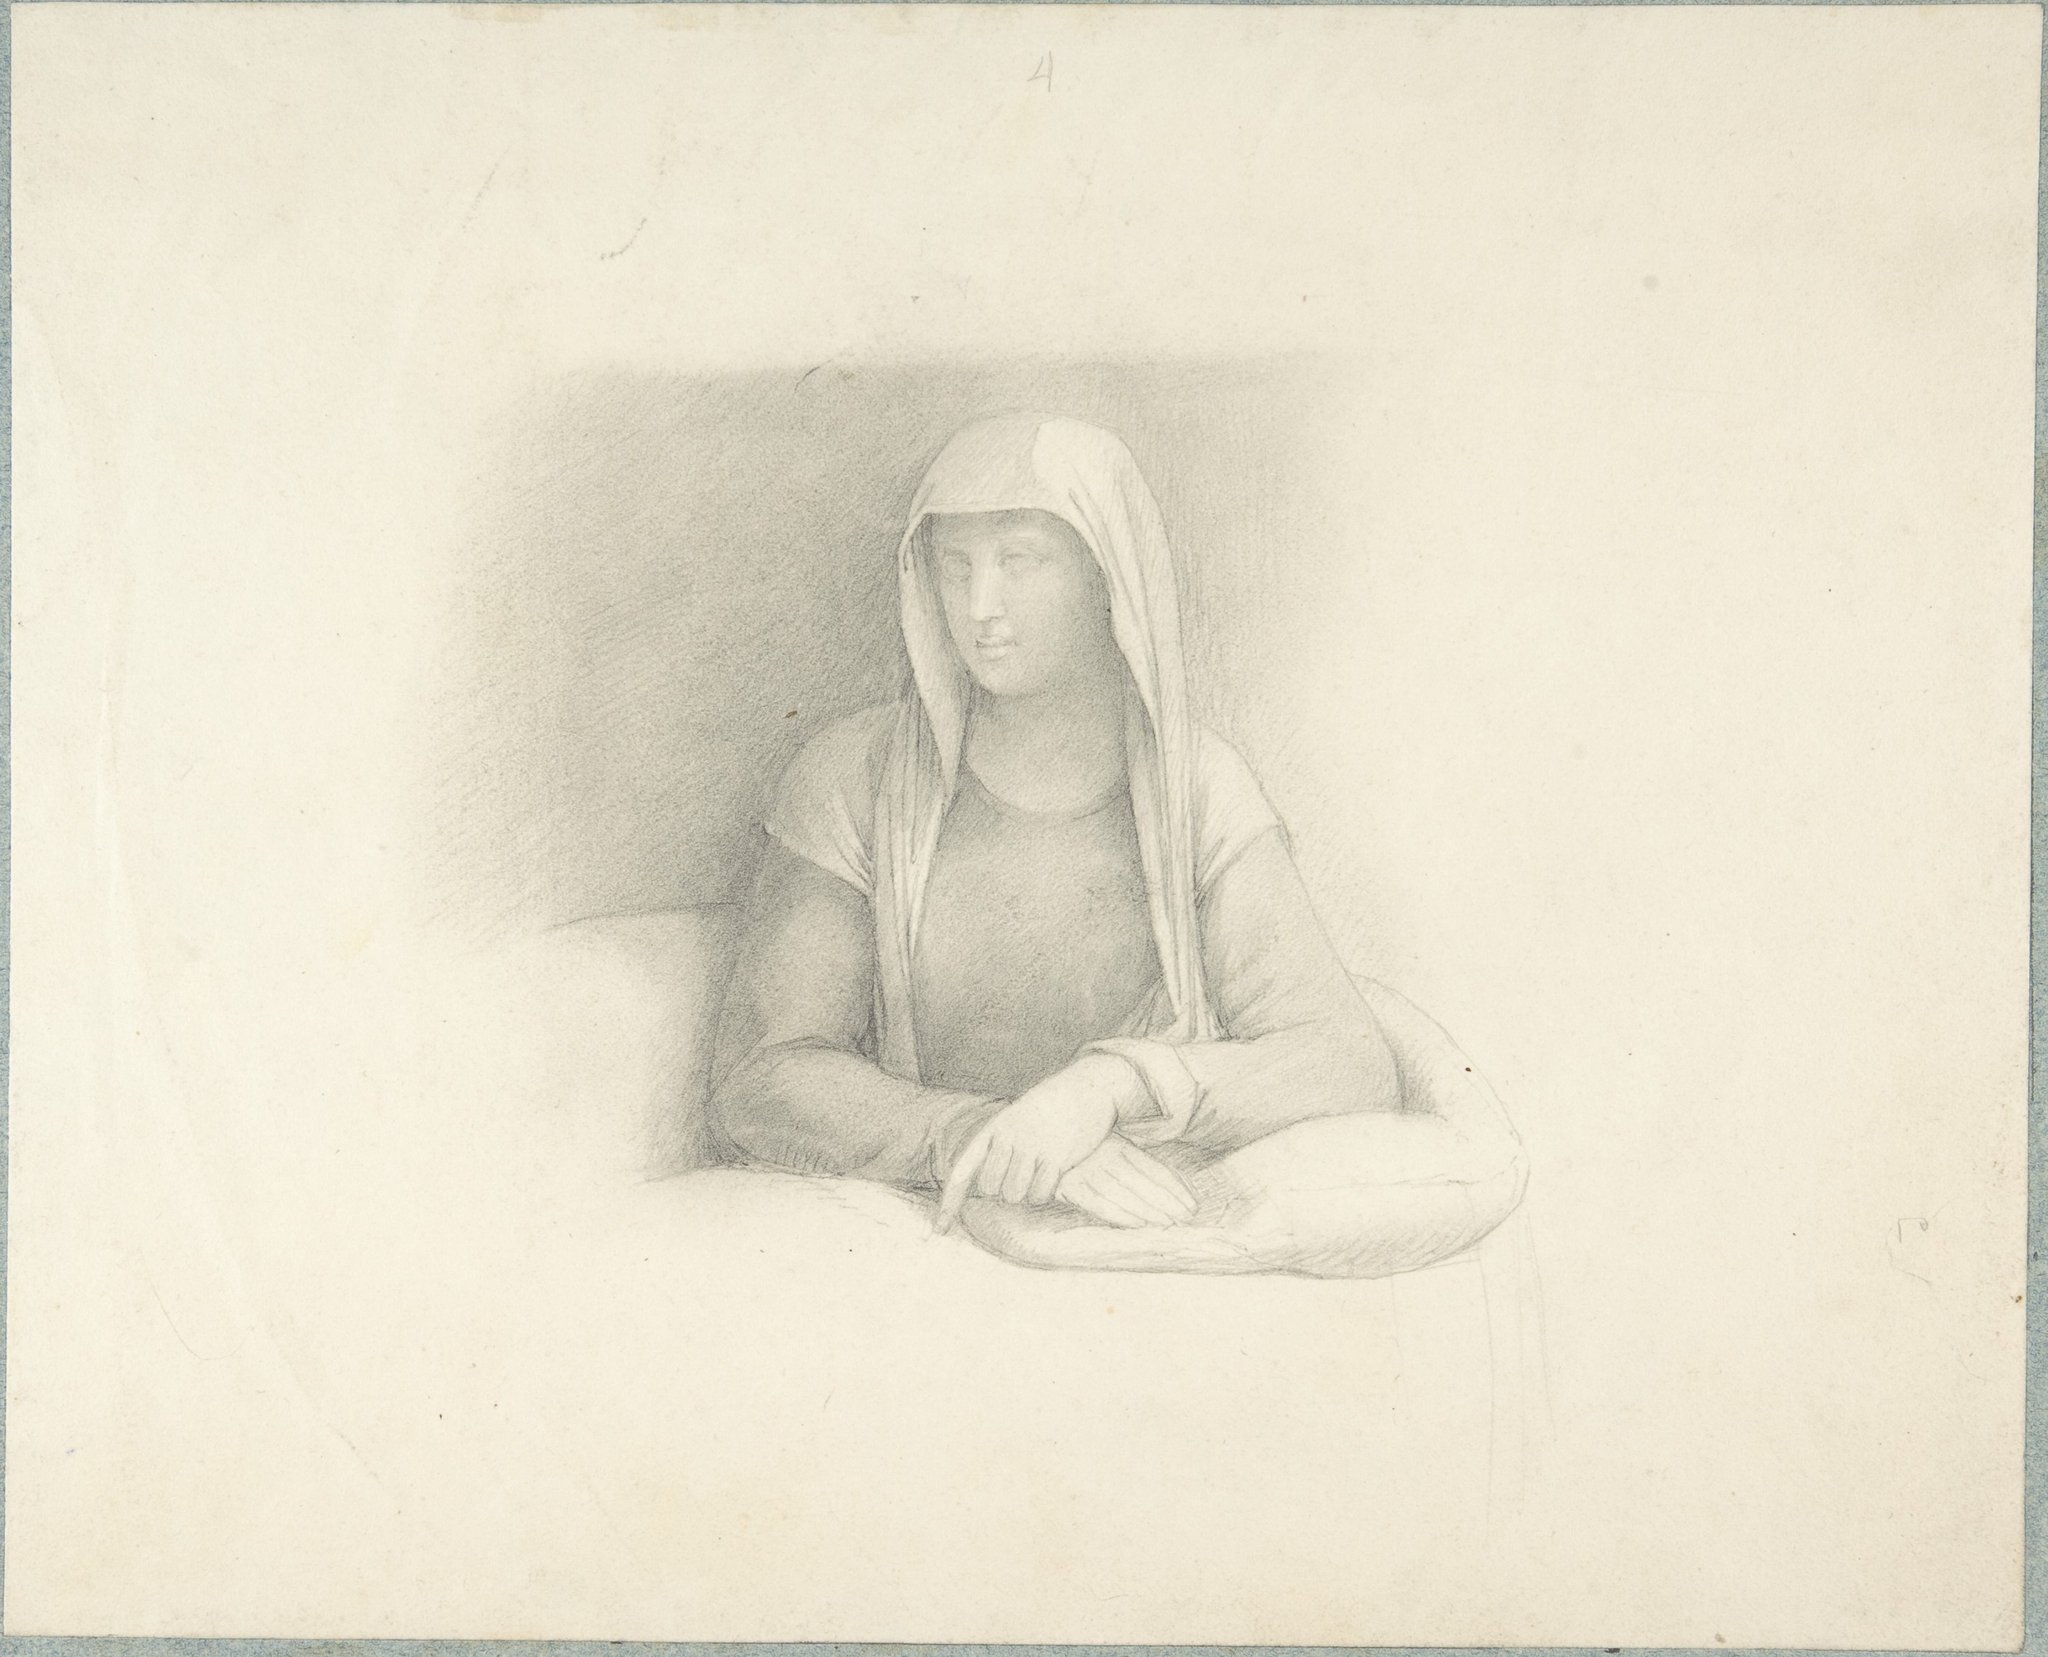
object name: drawing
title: Study of a Woman Leaning on a Cushion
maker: anonymous, german, 19th century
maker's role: artist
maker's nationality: german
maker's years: 1800-1899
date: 1801-1900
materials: graphite, ink, paper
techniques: pen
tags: women